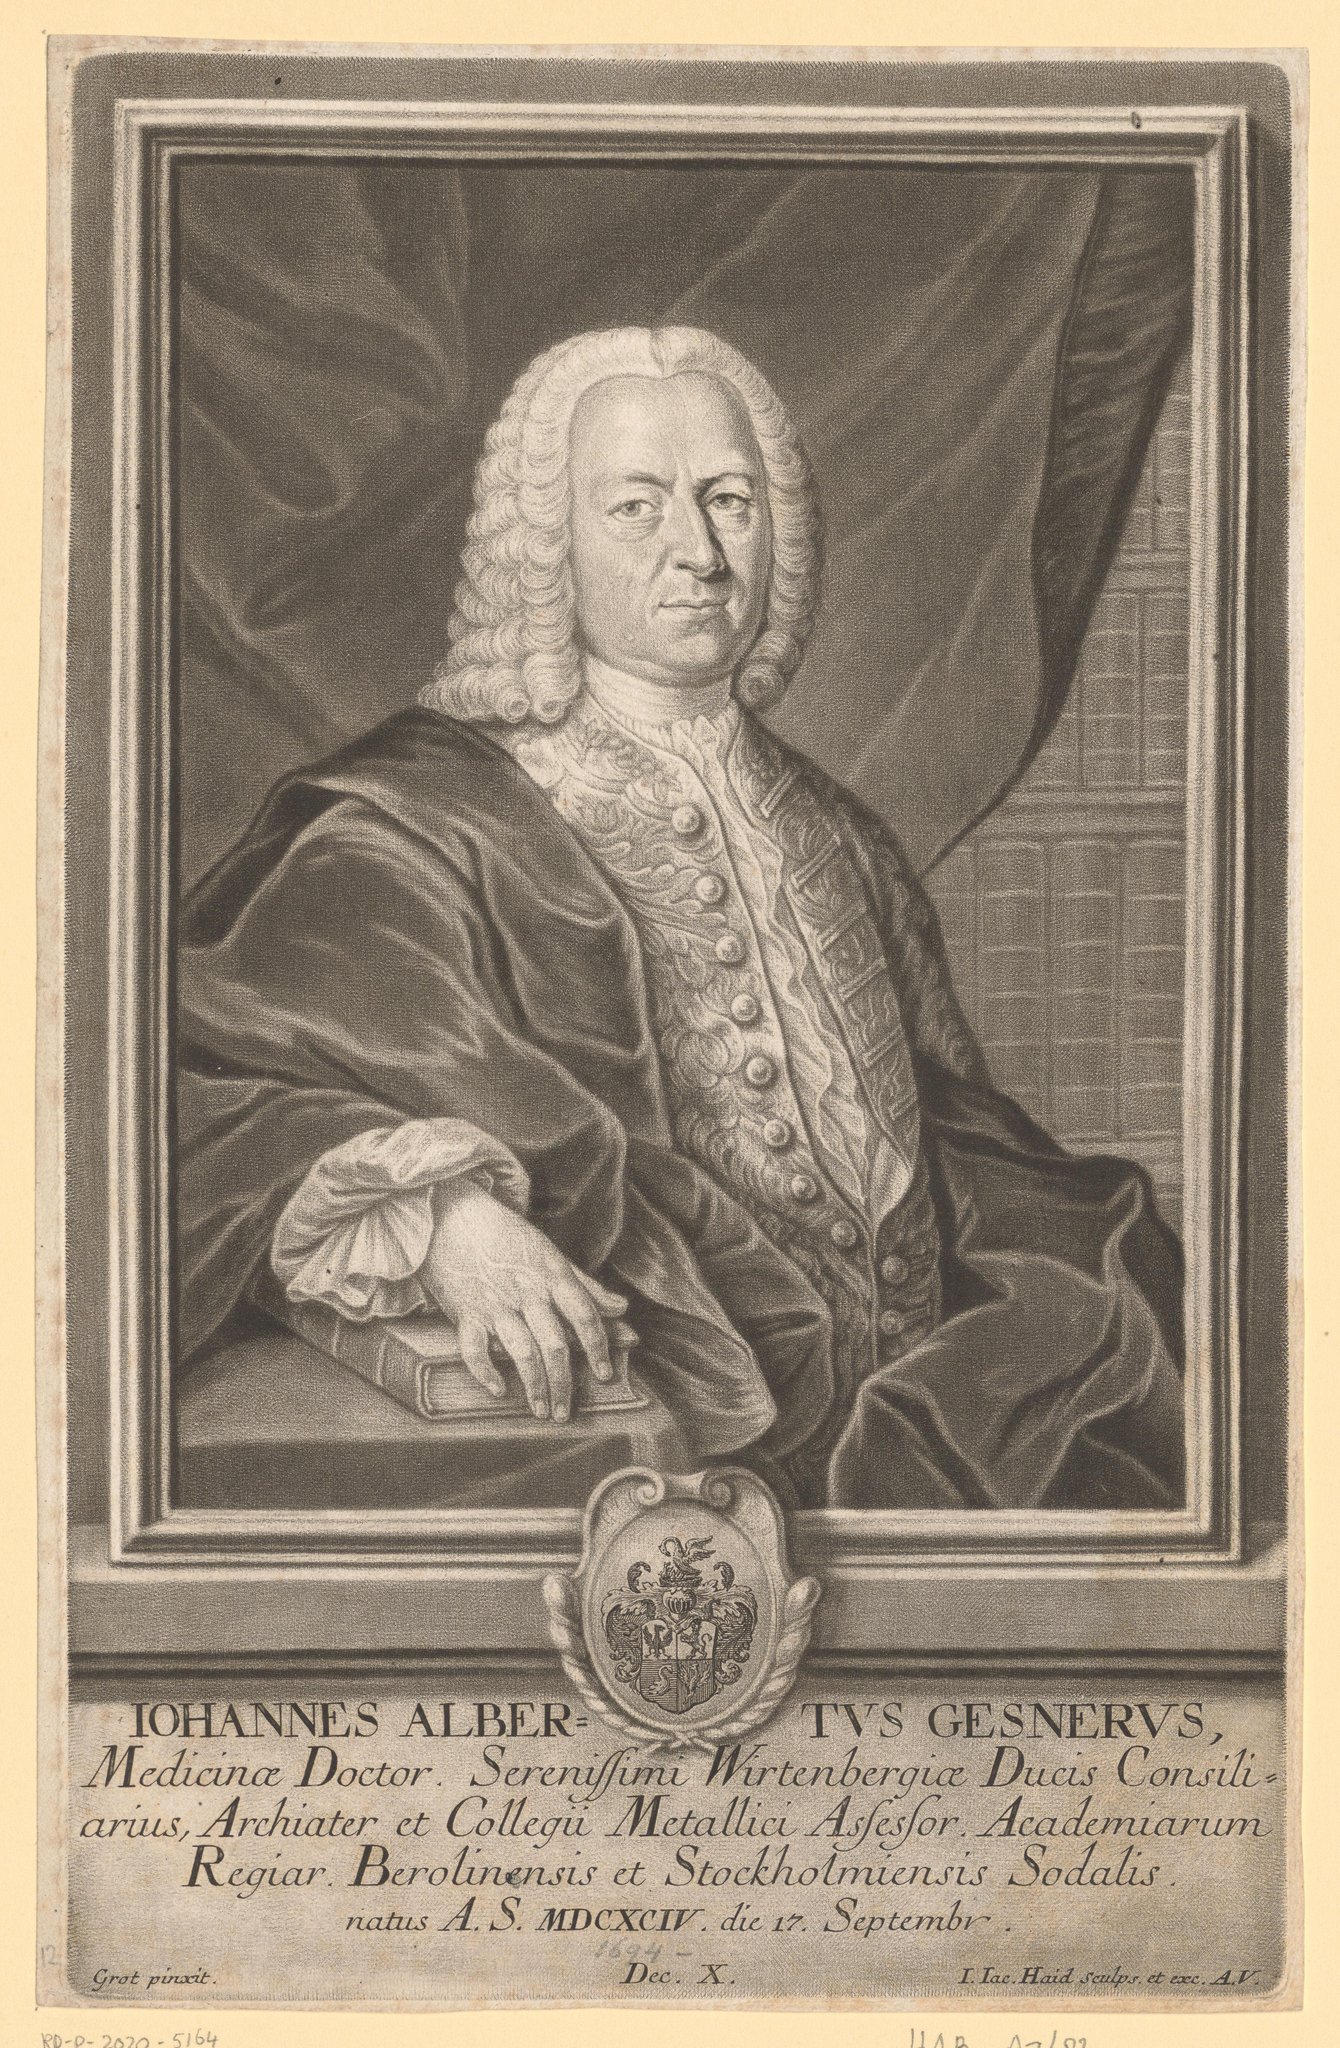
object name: book illustration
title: Portret van Johann Albrecht Gesner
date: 1755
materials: paper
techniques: etching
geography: augsburg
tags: historical persons, physician, doctor, armorial bearing, heraldry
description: Prent uit: Brucker, Johann Jakob. Bilder-Sal heutiges Tages lebender und durch Gelahrtheit berühmter Schriftsteller (...). Augsburg: Johann Jacob Haid, 1744.